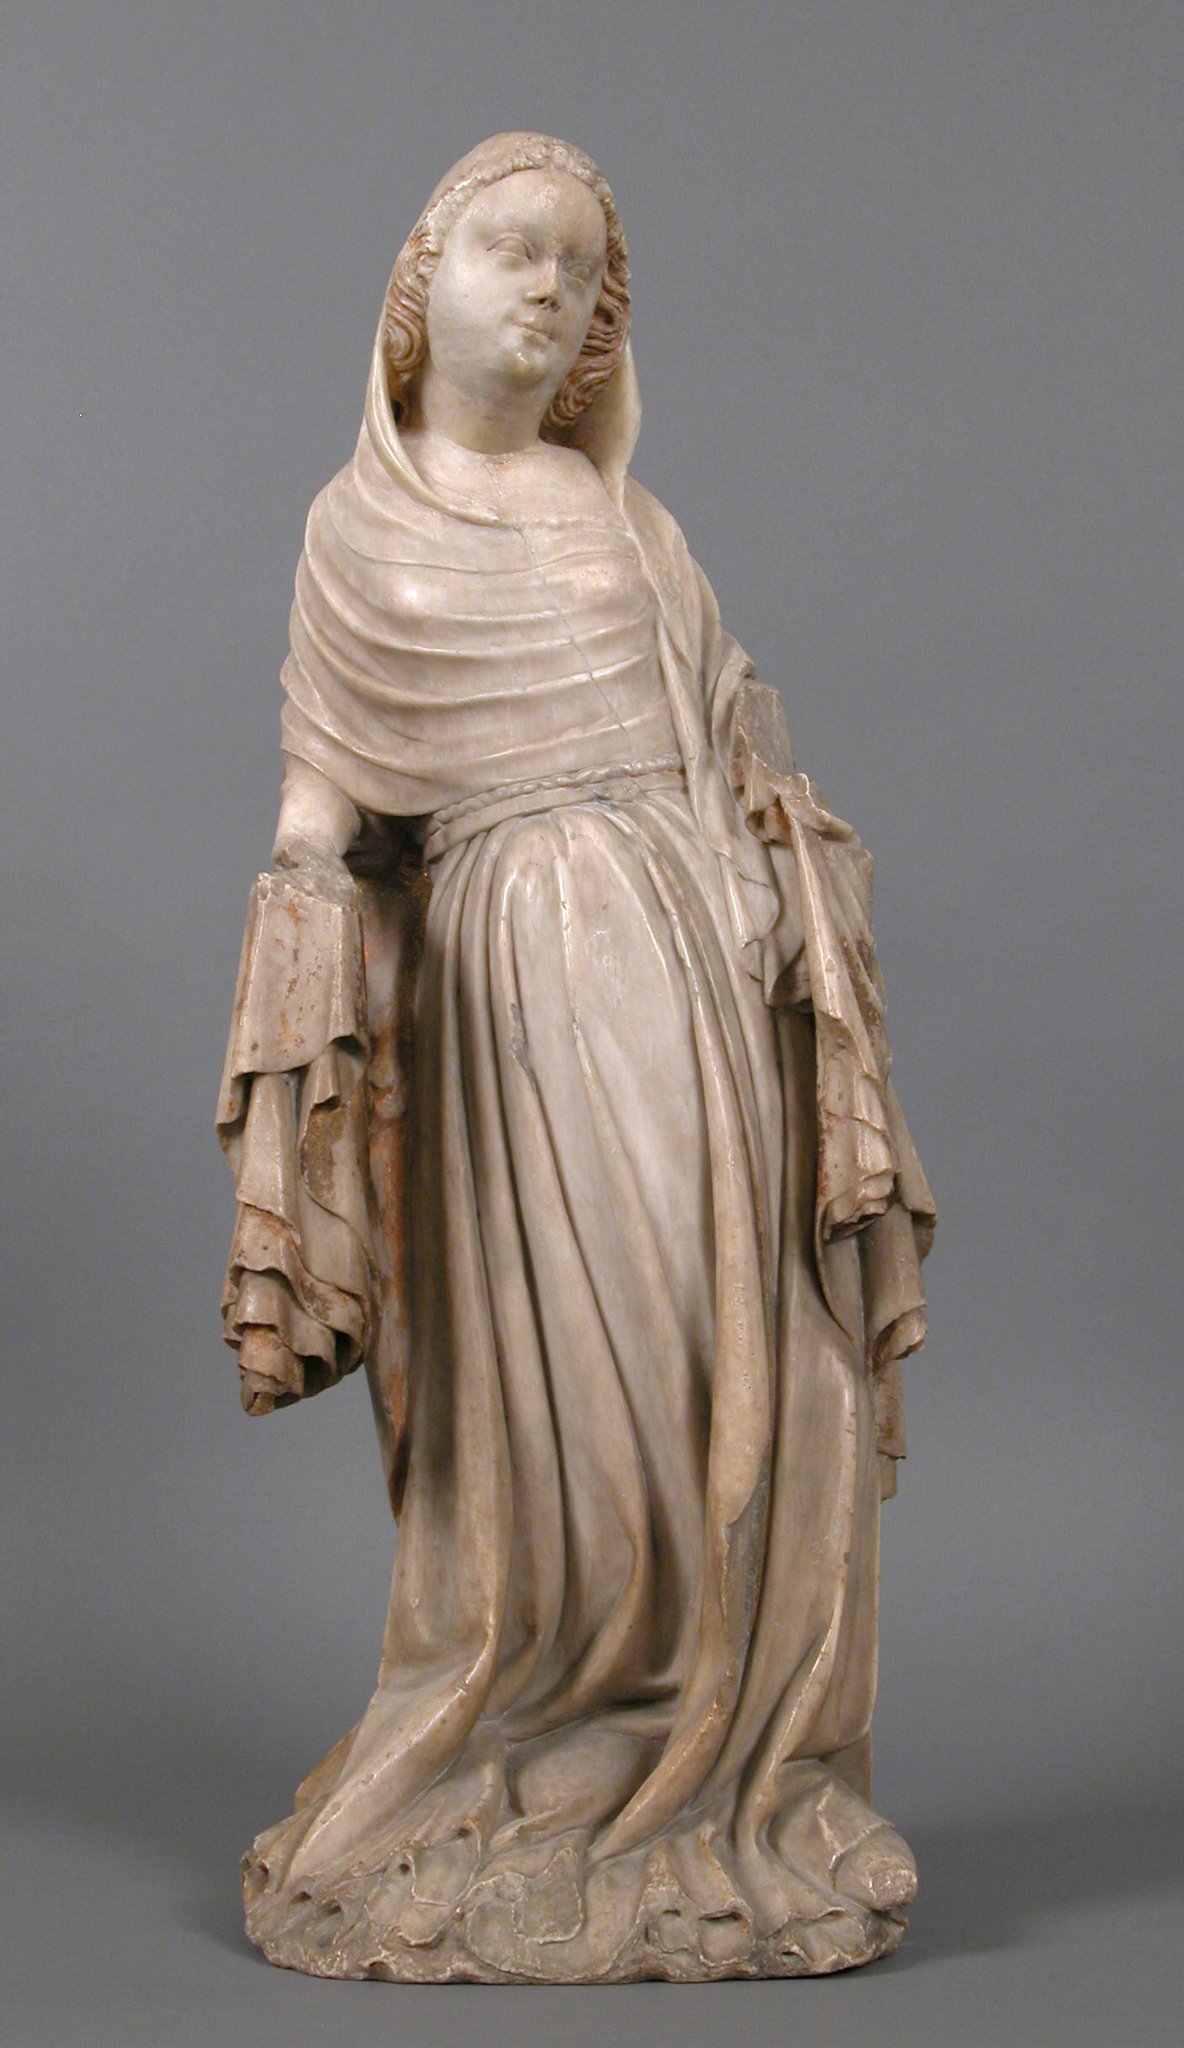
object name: statuette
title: Virgin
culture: french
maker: joan avesta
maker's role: artist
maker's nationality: spanish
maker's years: 1355-1390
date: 1370-1390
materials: alabaster, gilt, paint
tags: virgin mary